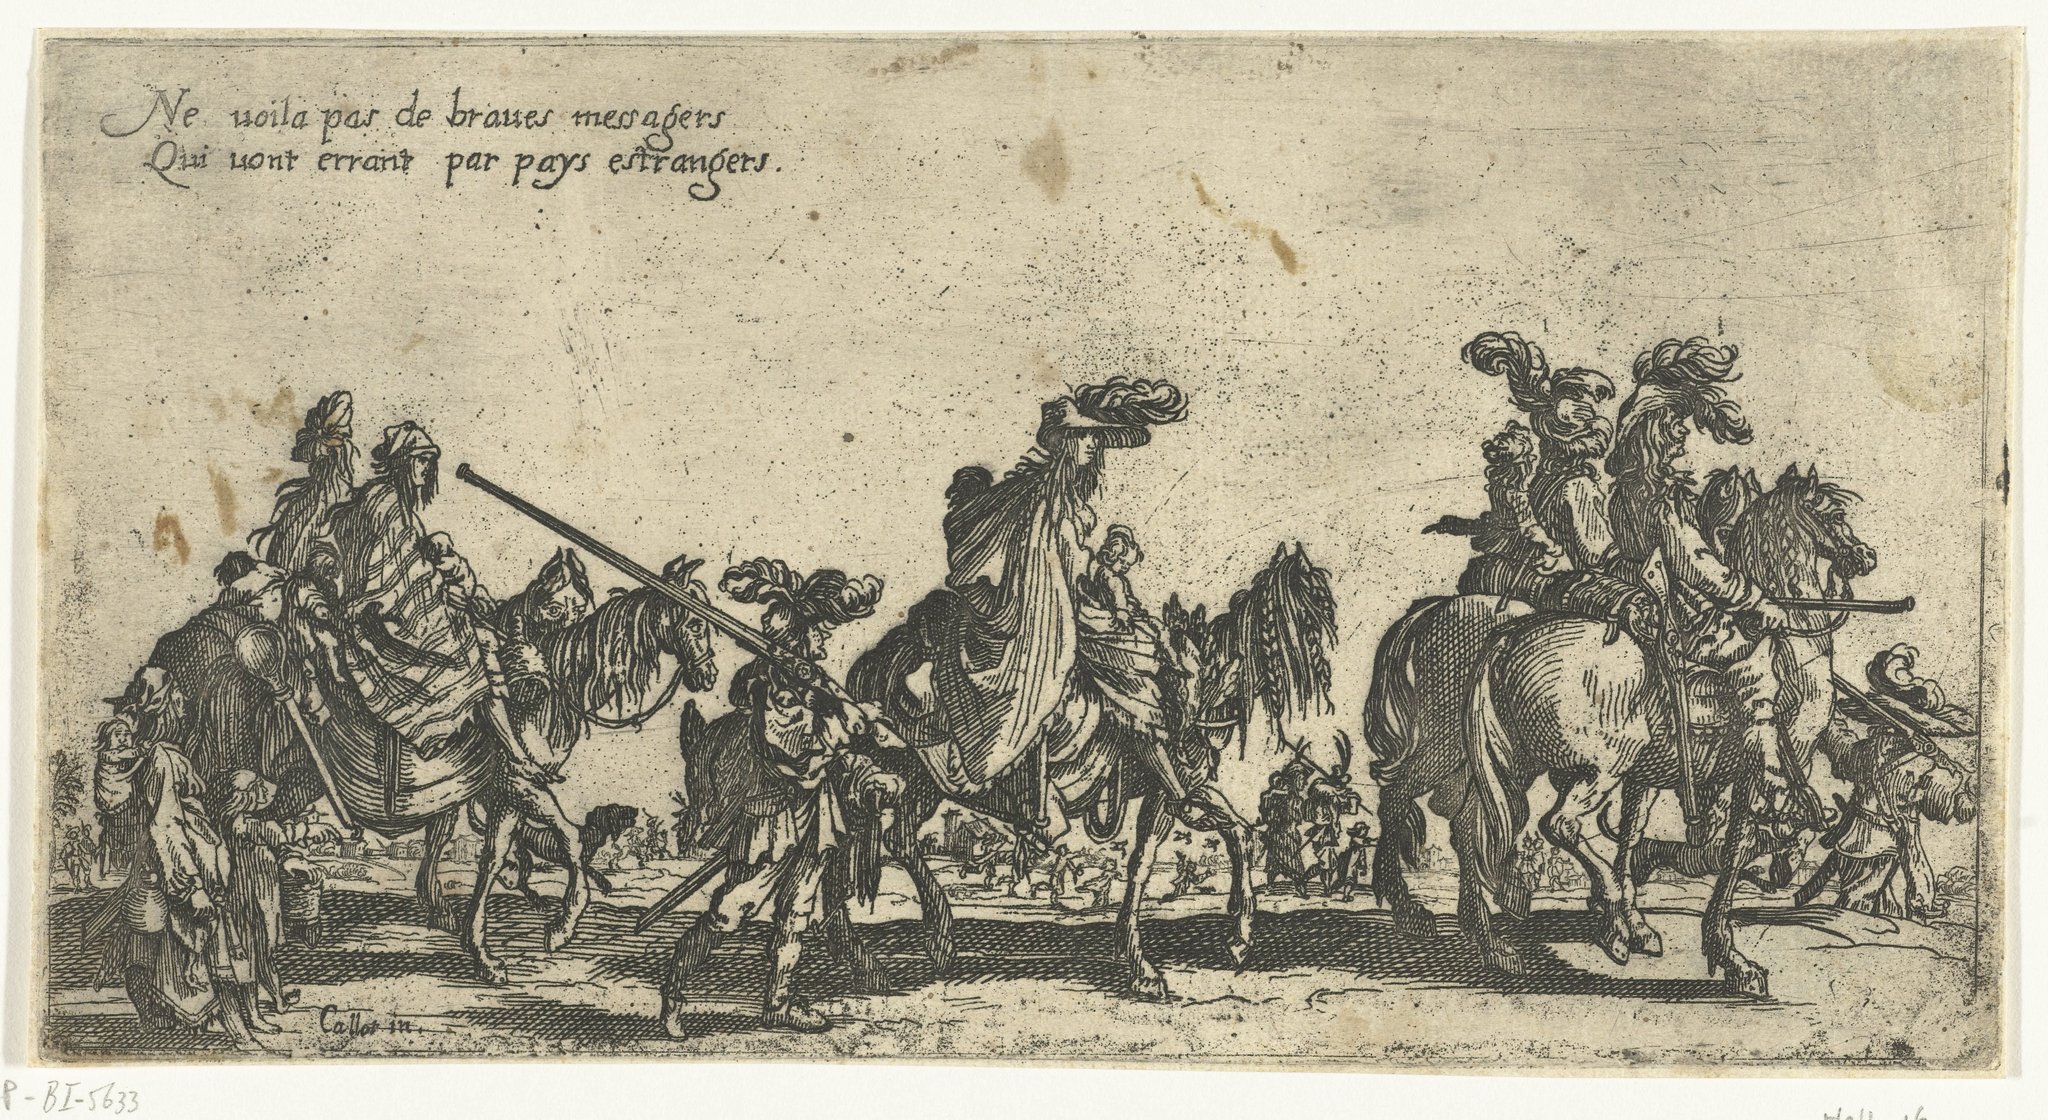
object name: print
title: Roma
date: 1603-1658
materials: paper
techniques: etching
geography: southern netherlands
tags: riding a horse, ass, or mule; rider, horseman, wandering communities: romani or roma, travelling; tourism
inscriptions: collector's mark: Lugt 2166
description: Zwervende zigeuners. Vijf zijn te paard. Ze rijden in profiel van links naar rechts. De prent heeft een Frans opschrift: 'Ne voila pas de braves messagers, qui vont errant par pays estrangers'.